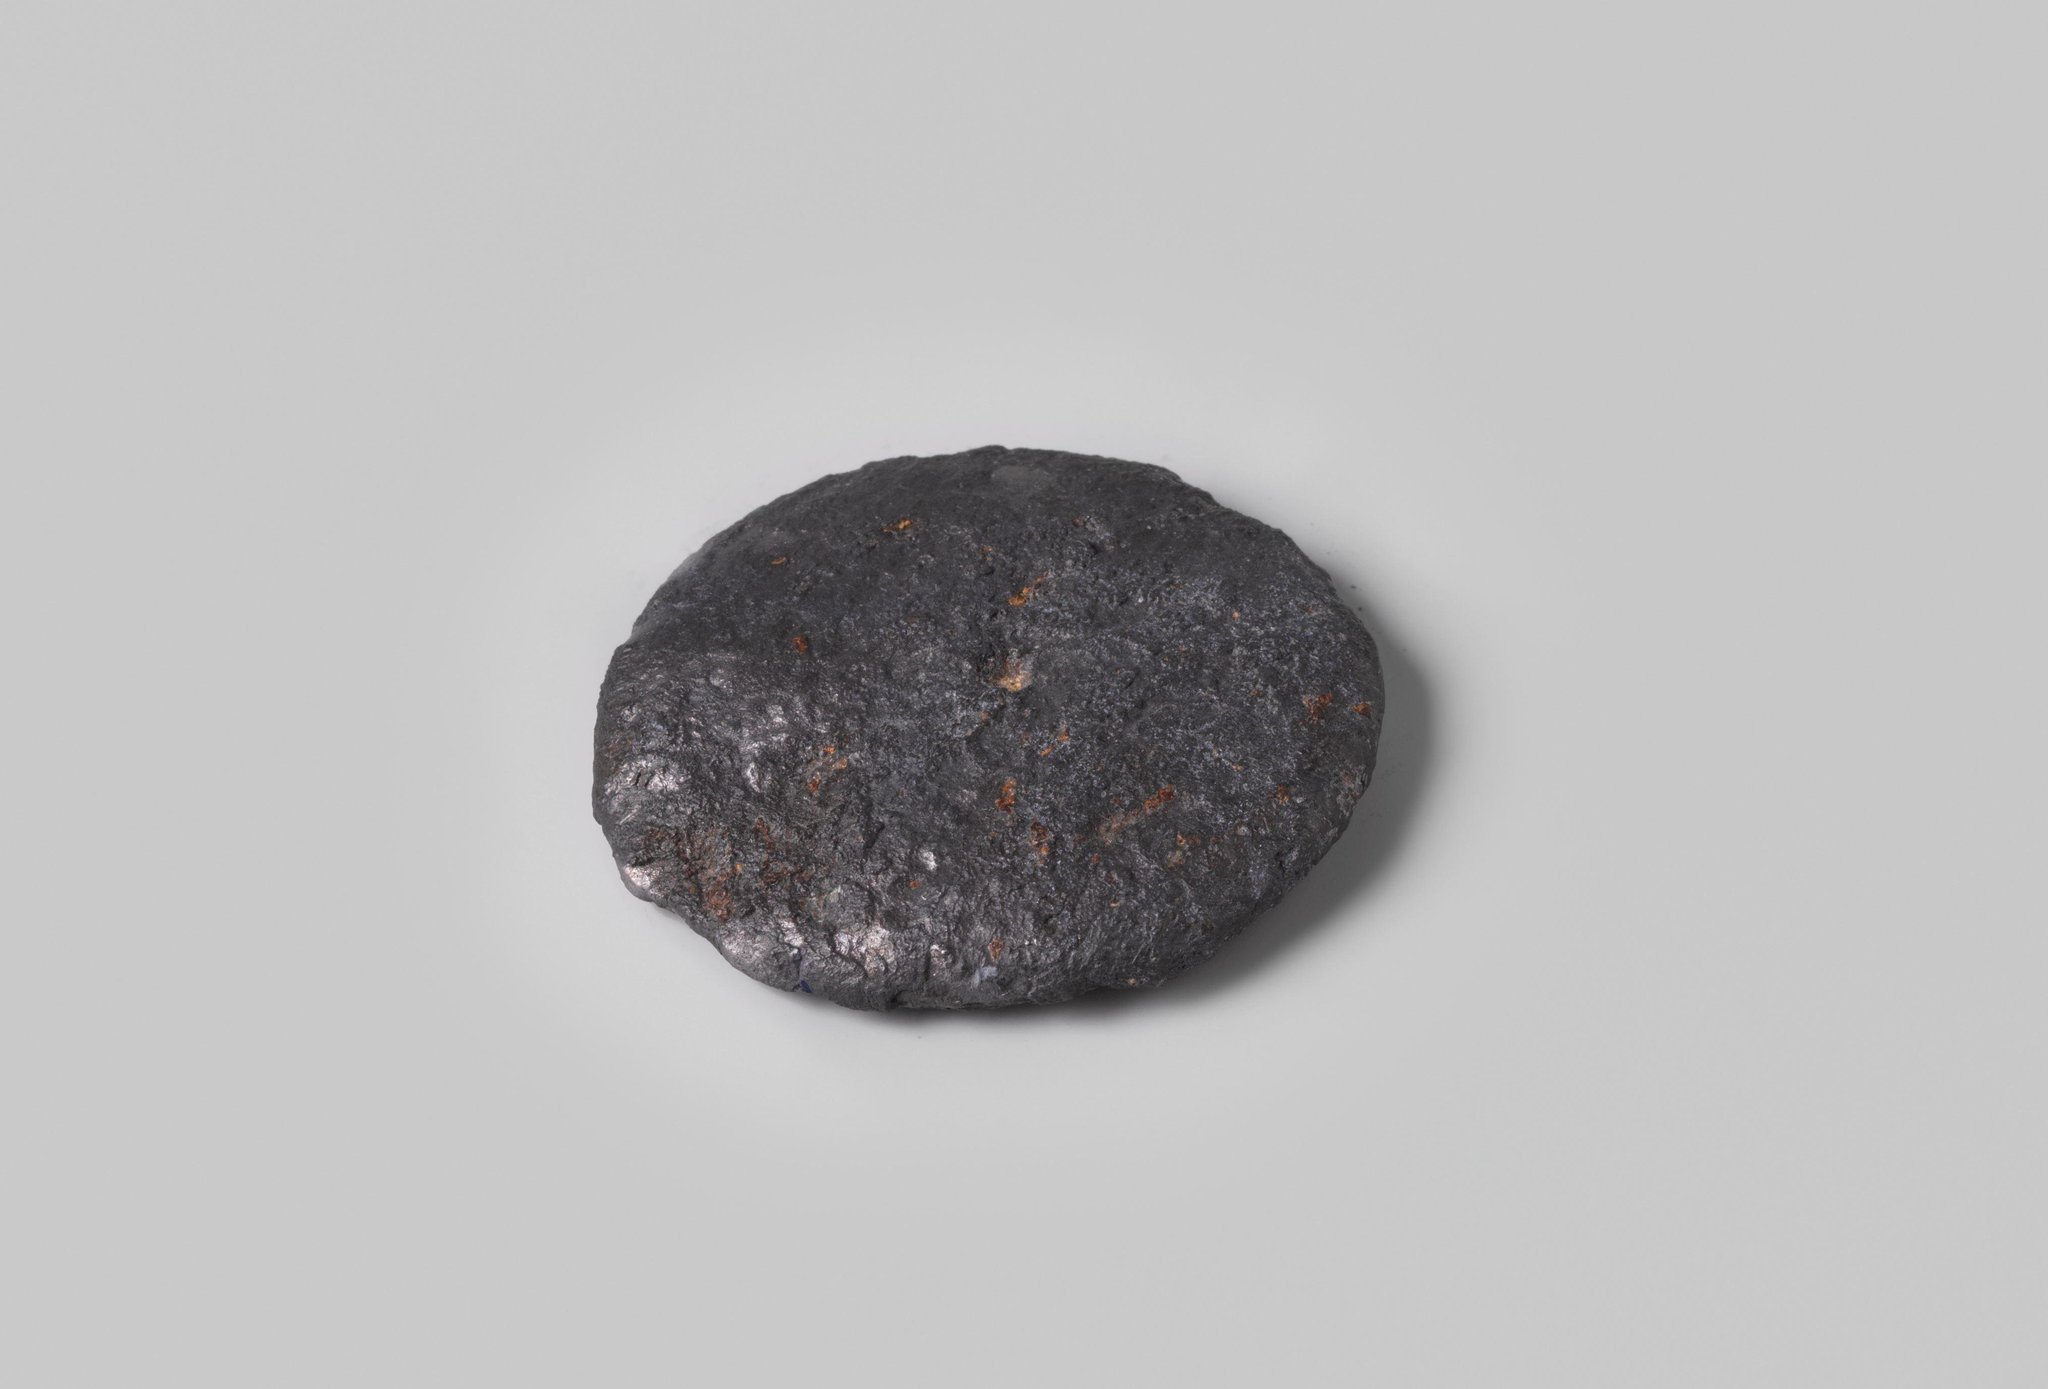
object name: weight scale component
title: Gewicht uit het wrak van de Oost-Indiëvaarder Hollandia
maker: Anonymous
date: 1700-1743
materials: lead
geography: netherlands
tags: verenigde oostindische compagnie, hollandia (schip), annet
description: Disc-shaped weight, sim. NG 1980-27H851, corroded.